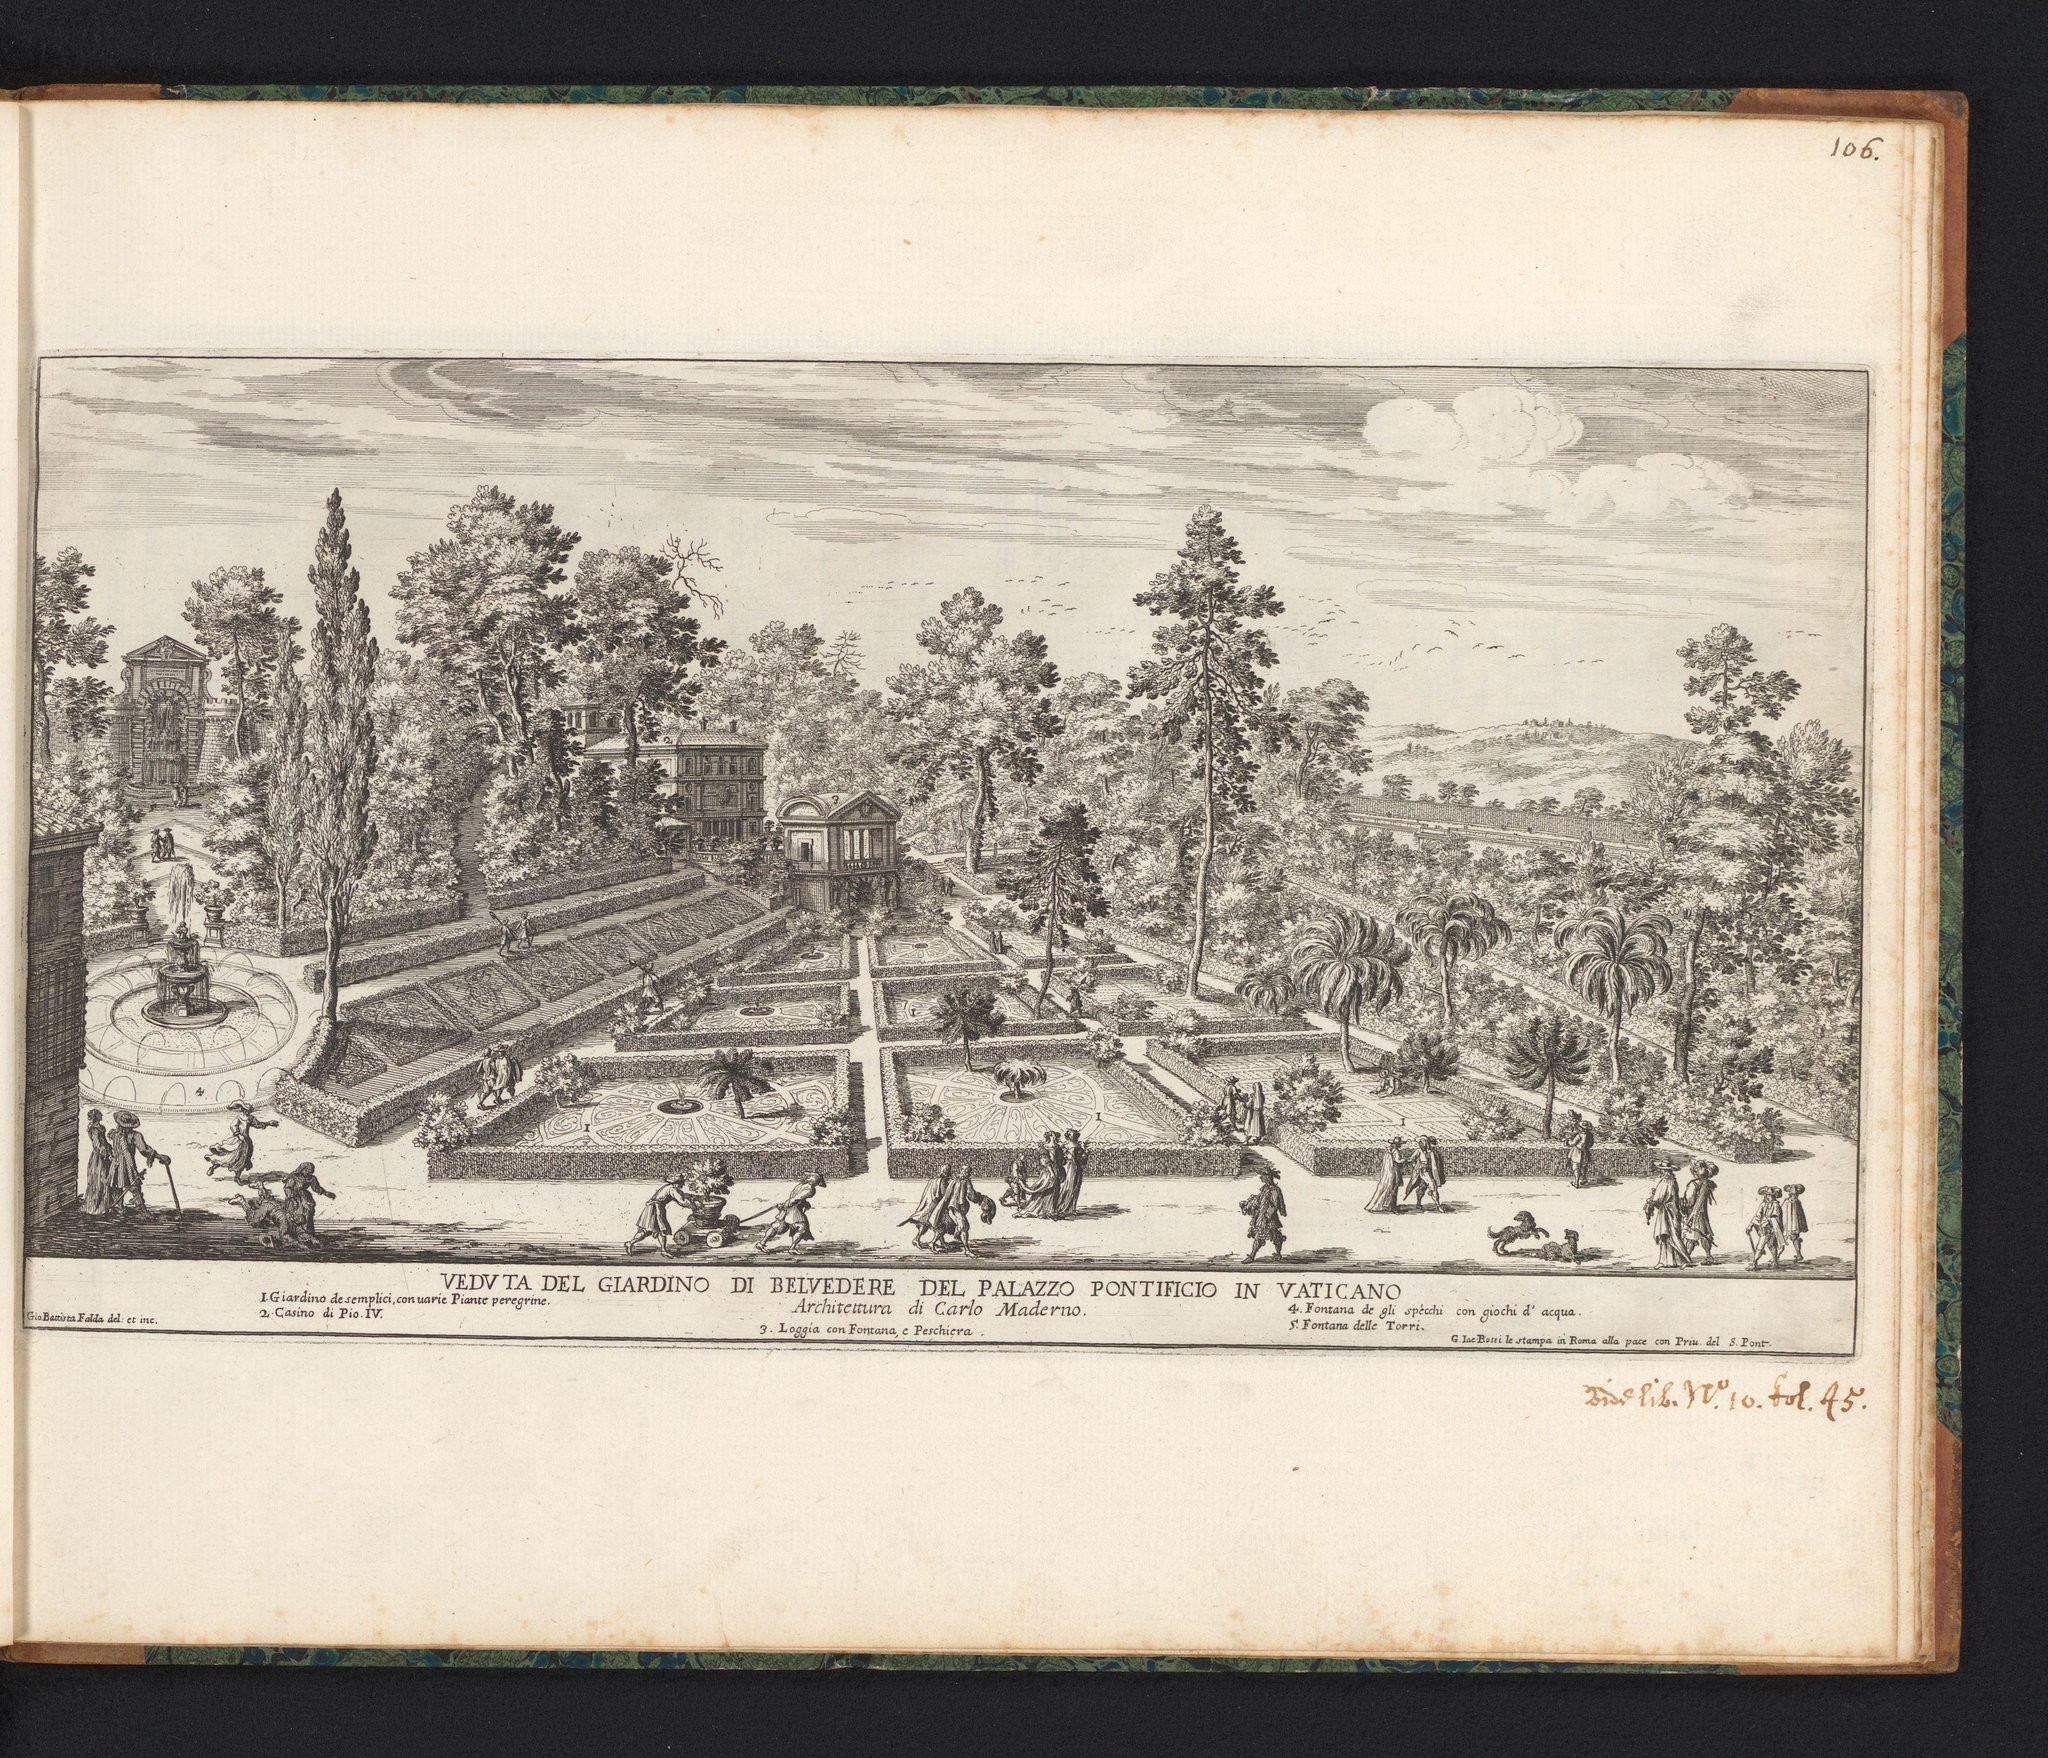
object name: print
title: Gezicht op de Vaticaanse Belvedere tuinen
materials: paper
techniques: etching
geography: rome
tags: garden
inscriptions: number: ‘106’, inscription: ‘Ende lib. No. 10. fol. 45.’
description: Gezicht op de Vaticaanse Belvedere tuinen. Mensen werken en flaneren in de tuin. Links een fontein. In de ondermarge de titel en een verklarende lijst met nummers. Prent maakt deel uit van een album.